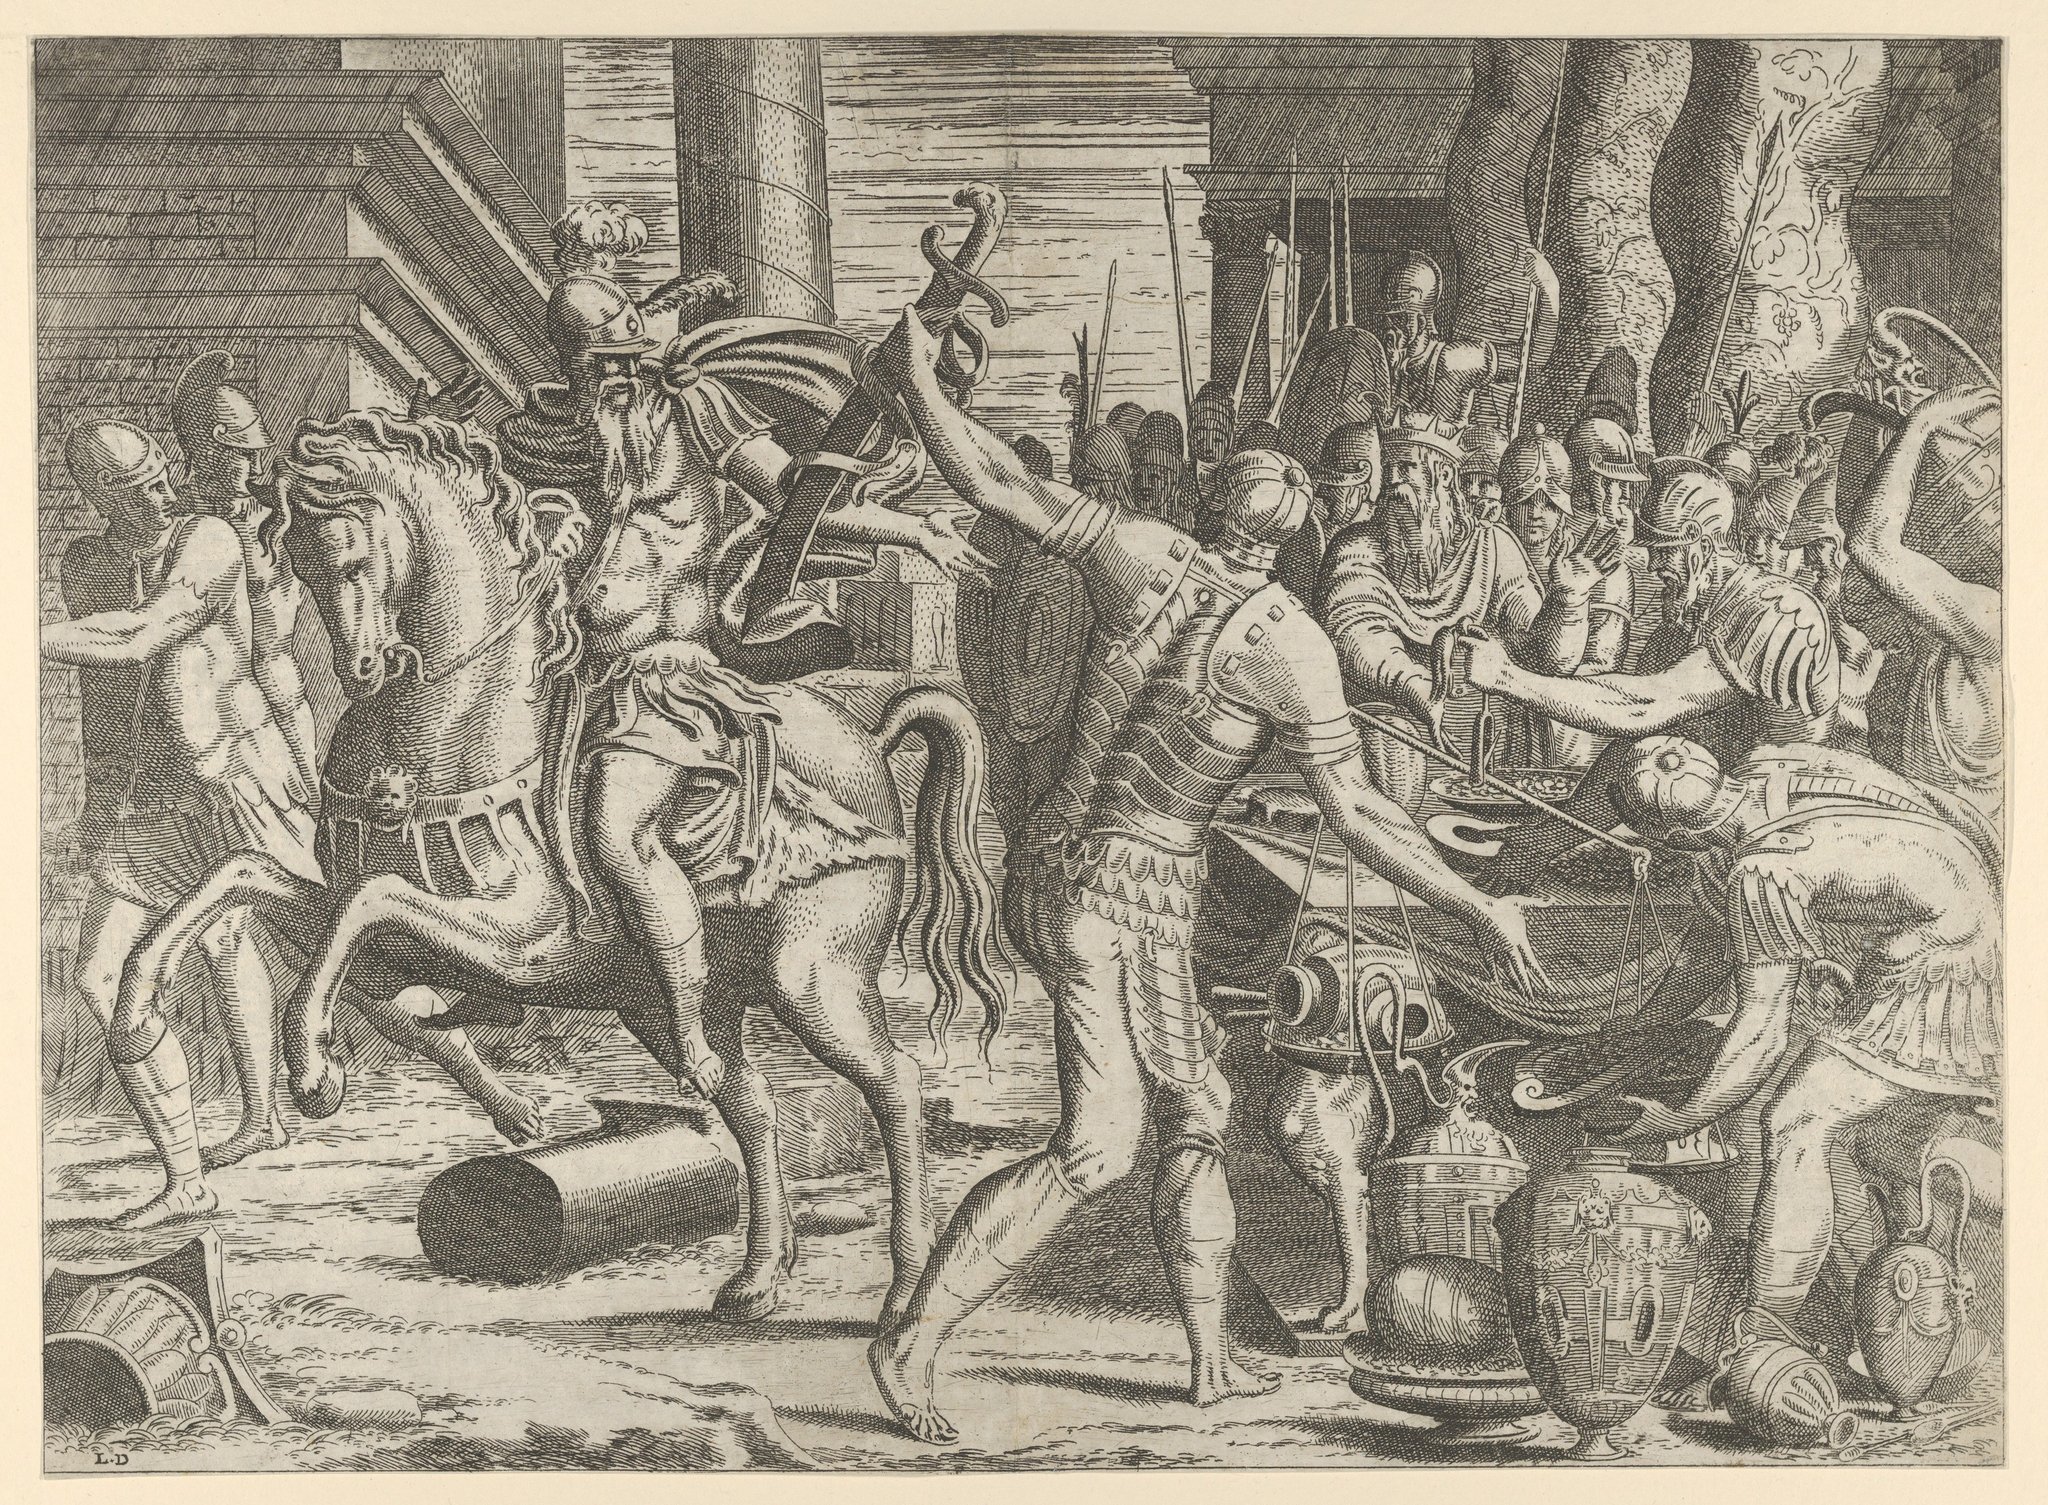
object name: print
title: Brennus throwing his sword on the scales before Camillus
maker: léon davent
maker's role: artist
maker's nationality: french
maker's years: 1540-1556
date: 1540-1556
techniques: etching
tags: soldiers,men,horses,scales